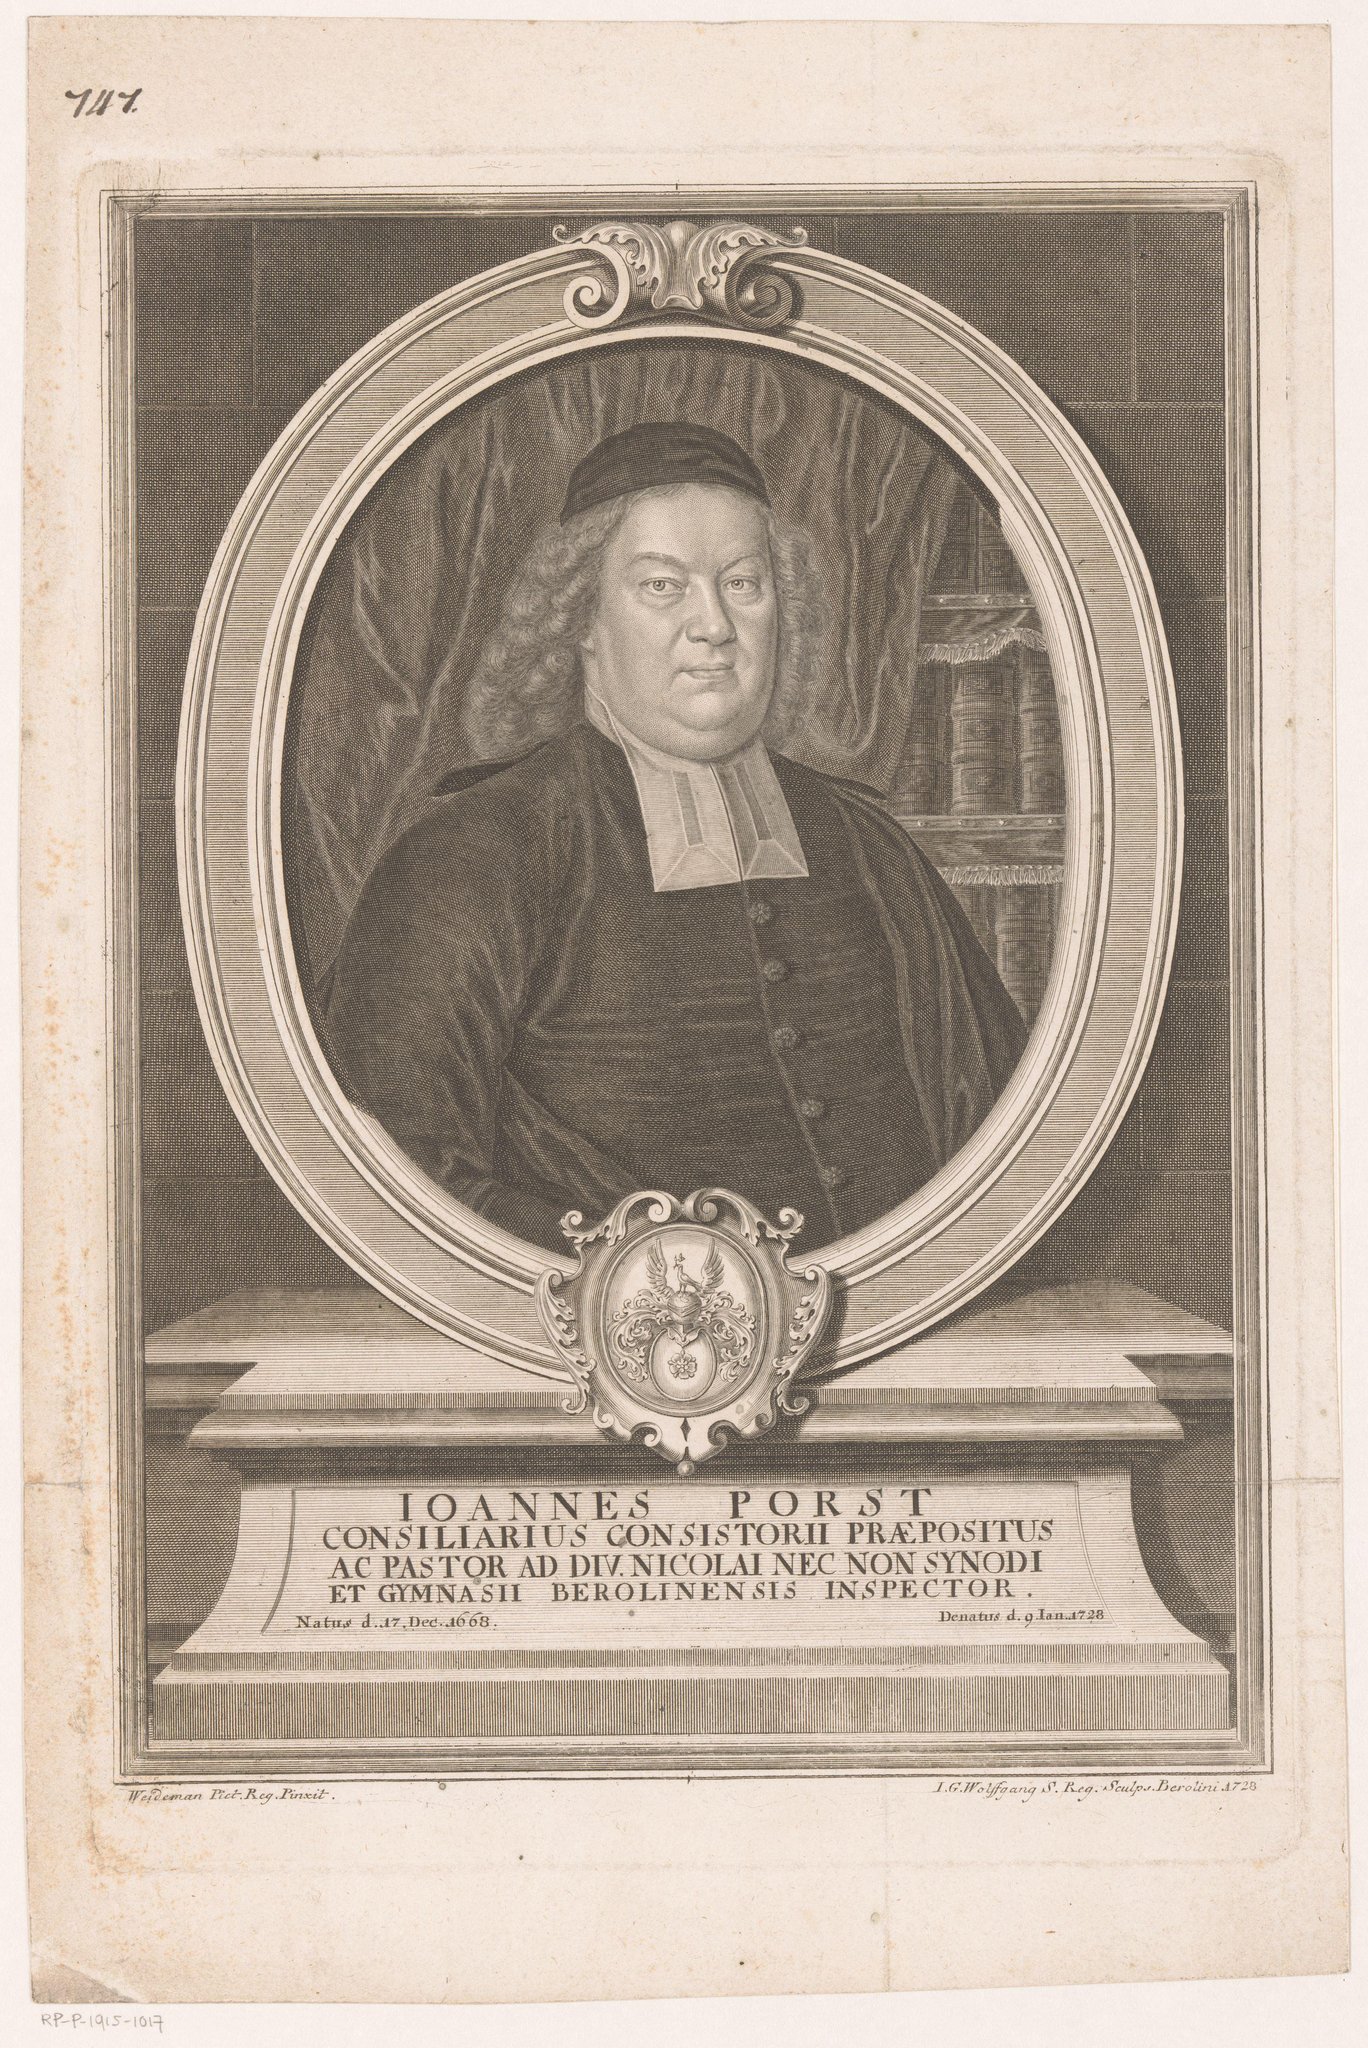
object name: print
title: Portret van Johann Porst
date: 1728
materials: paper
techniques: engraving, etching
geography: berlin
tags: berlin, bookshelves, historical persons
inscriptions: number: ‘747’, collector's mark: Lugt 2228